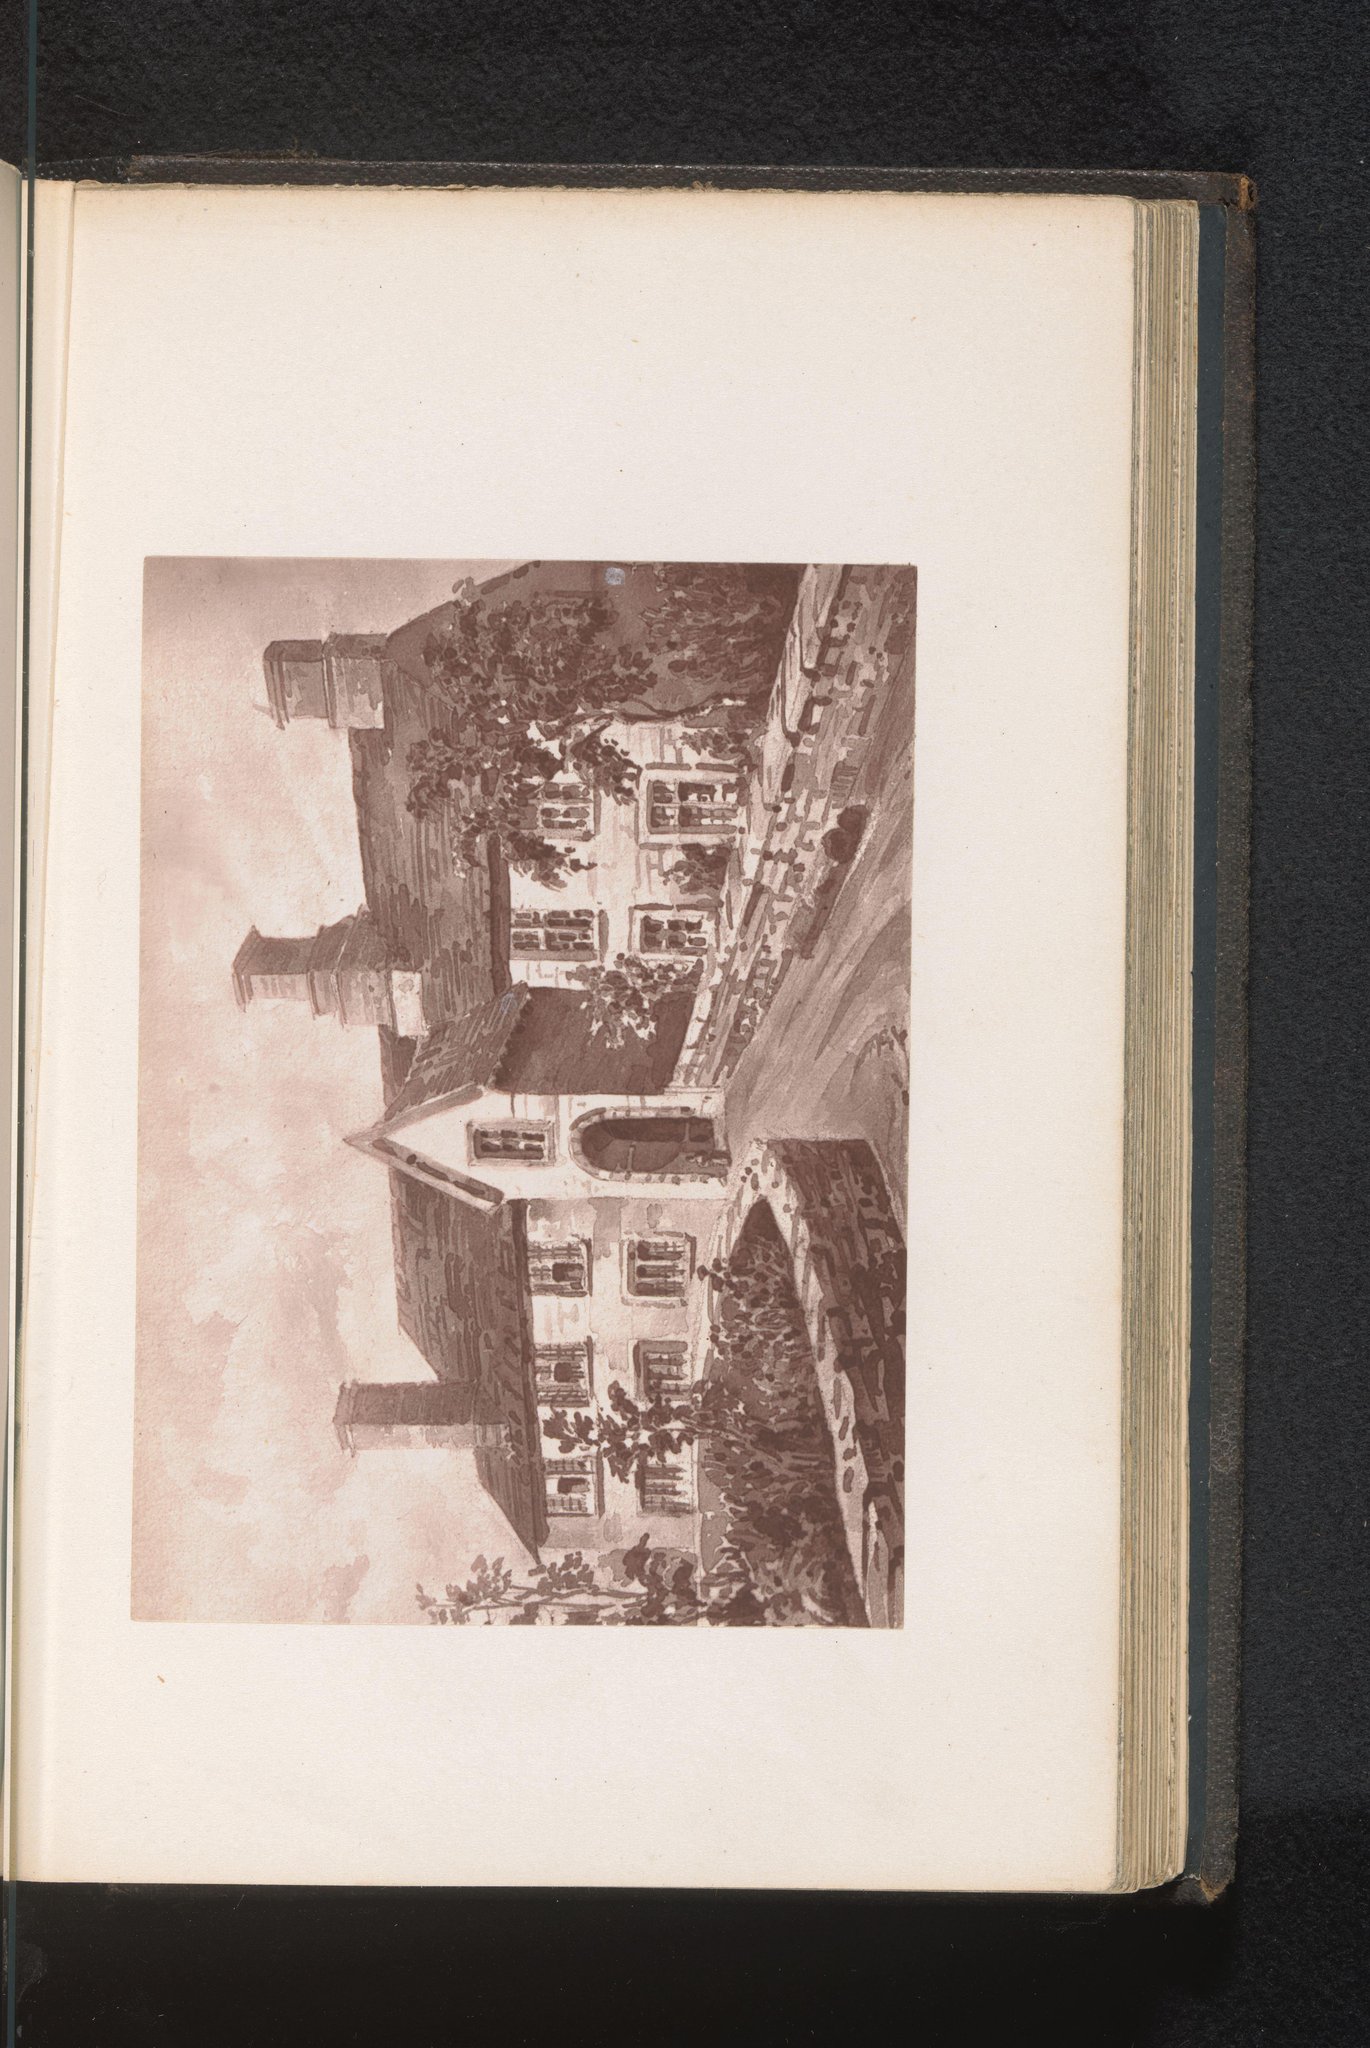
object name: page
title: Fotoreproductie van een schildering, voorstellende een gezicht op de voorgevel van Court Farm te Abbotskerswell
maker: Anonymous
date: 1866-1876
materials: paper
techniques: woodburytype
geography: abbotskerswell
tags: façade (of house or building), farm (building)